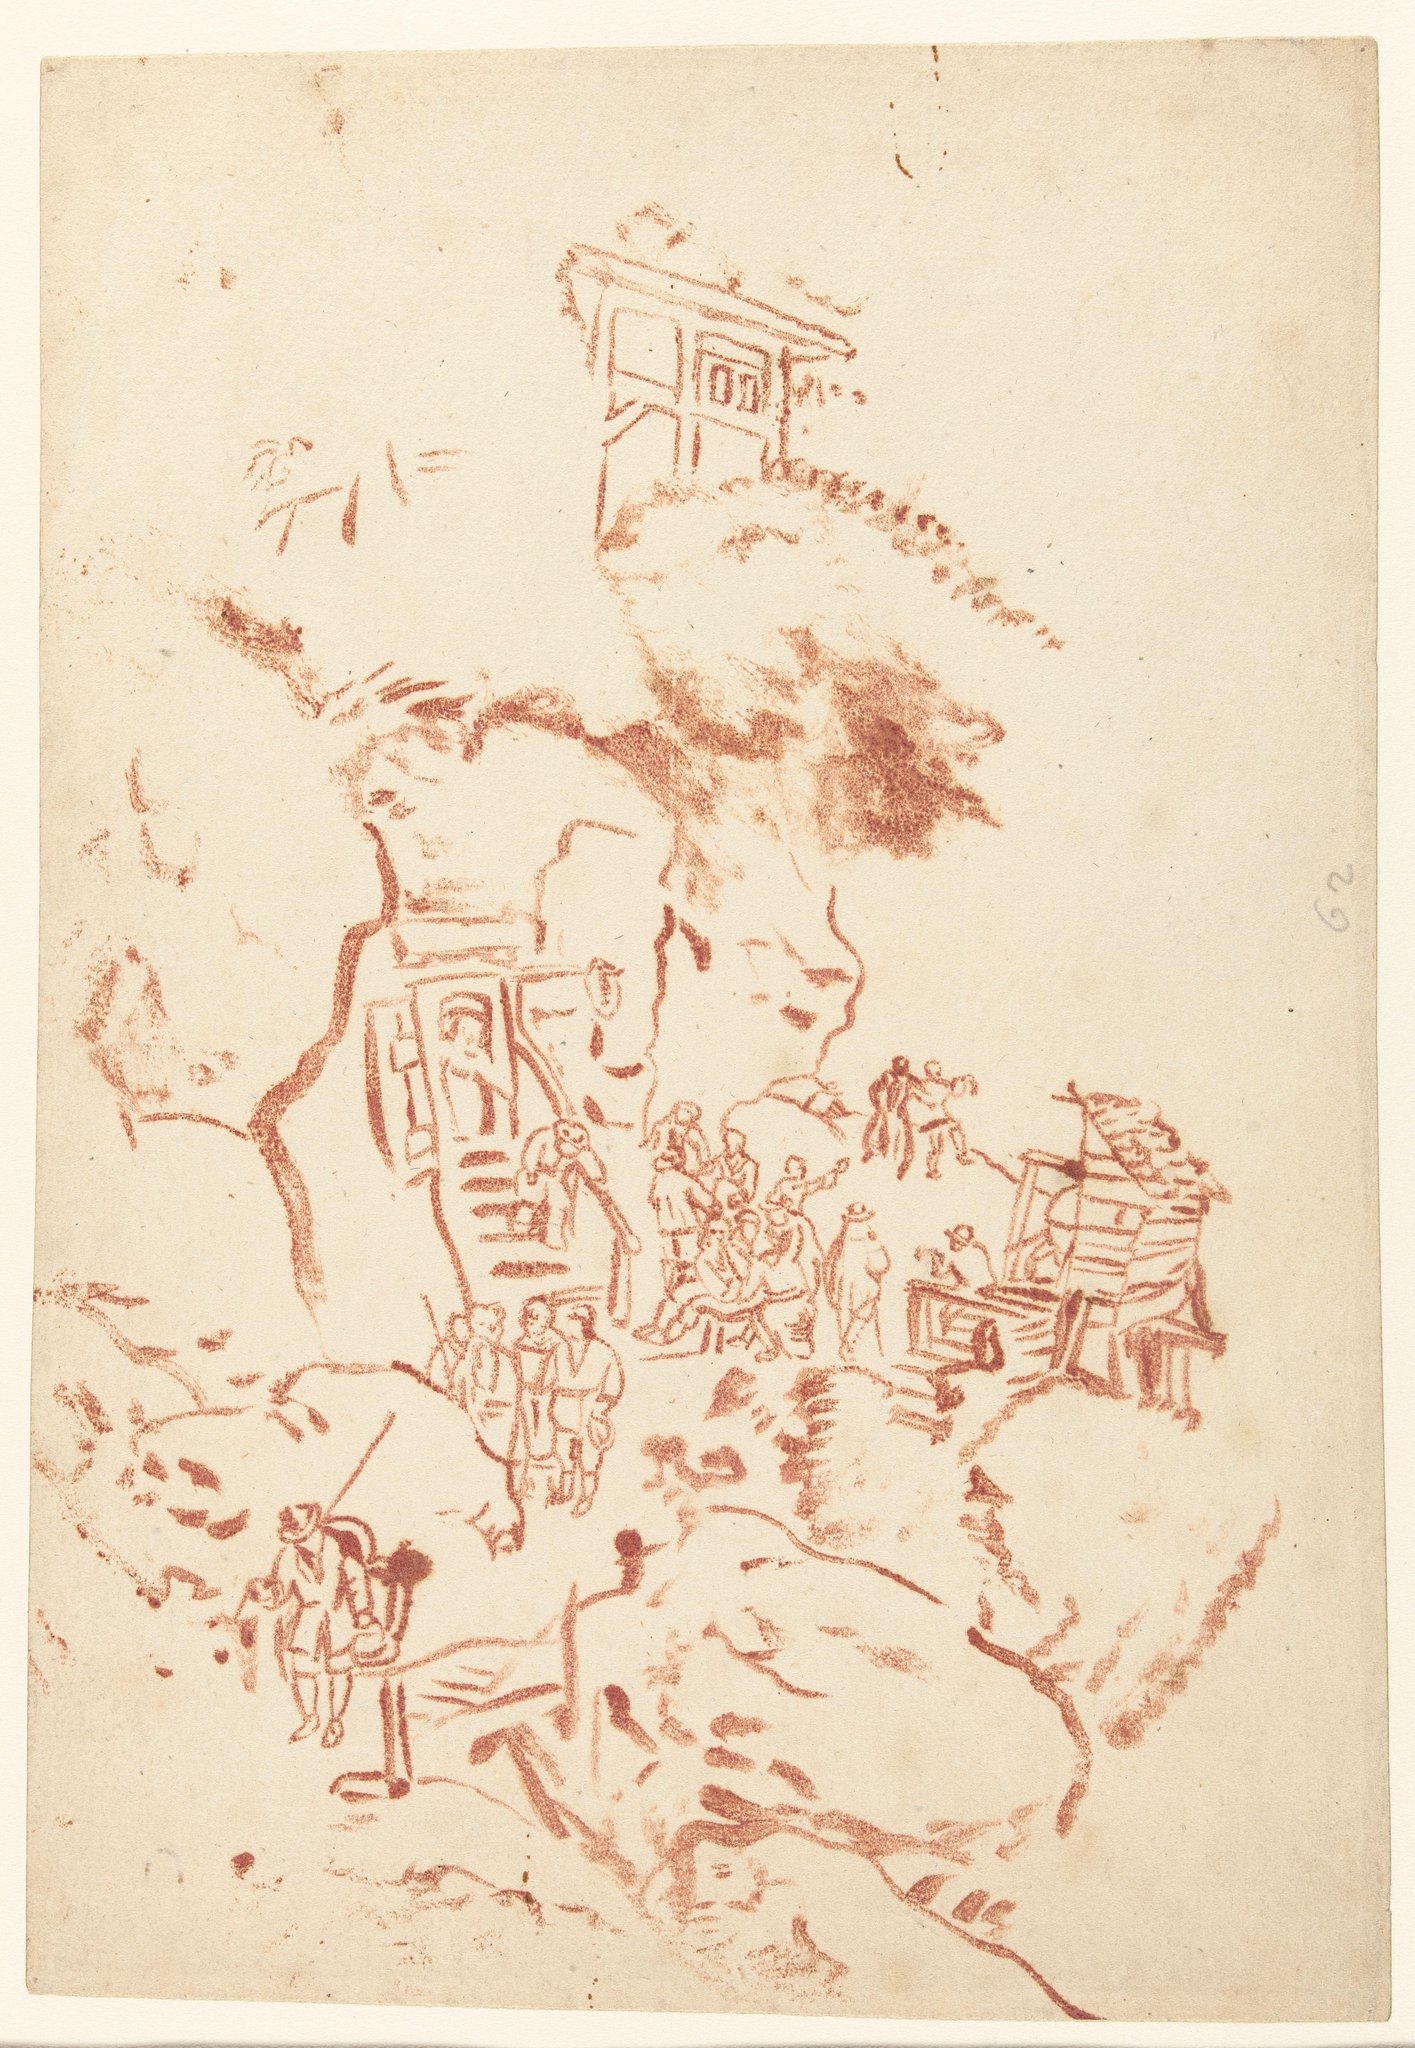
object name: drawing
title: Reisschetsen gemaakt in Indië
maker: Anonymous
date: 1700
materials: chalk, paper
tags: batavia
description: Bergwand met rotswoningen en een bergpad met figuren, in de trant van een Chinese tekening.